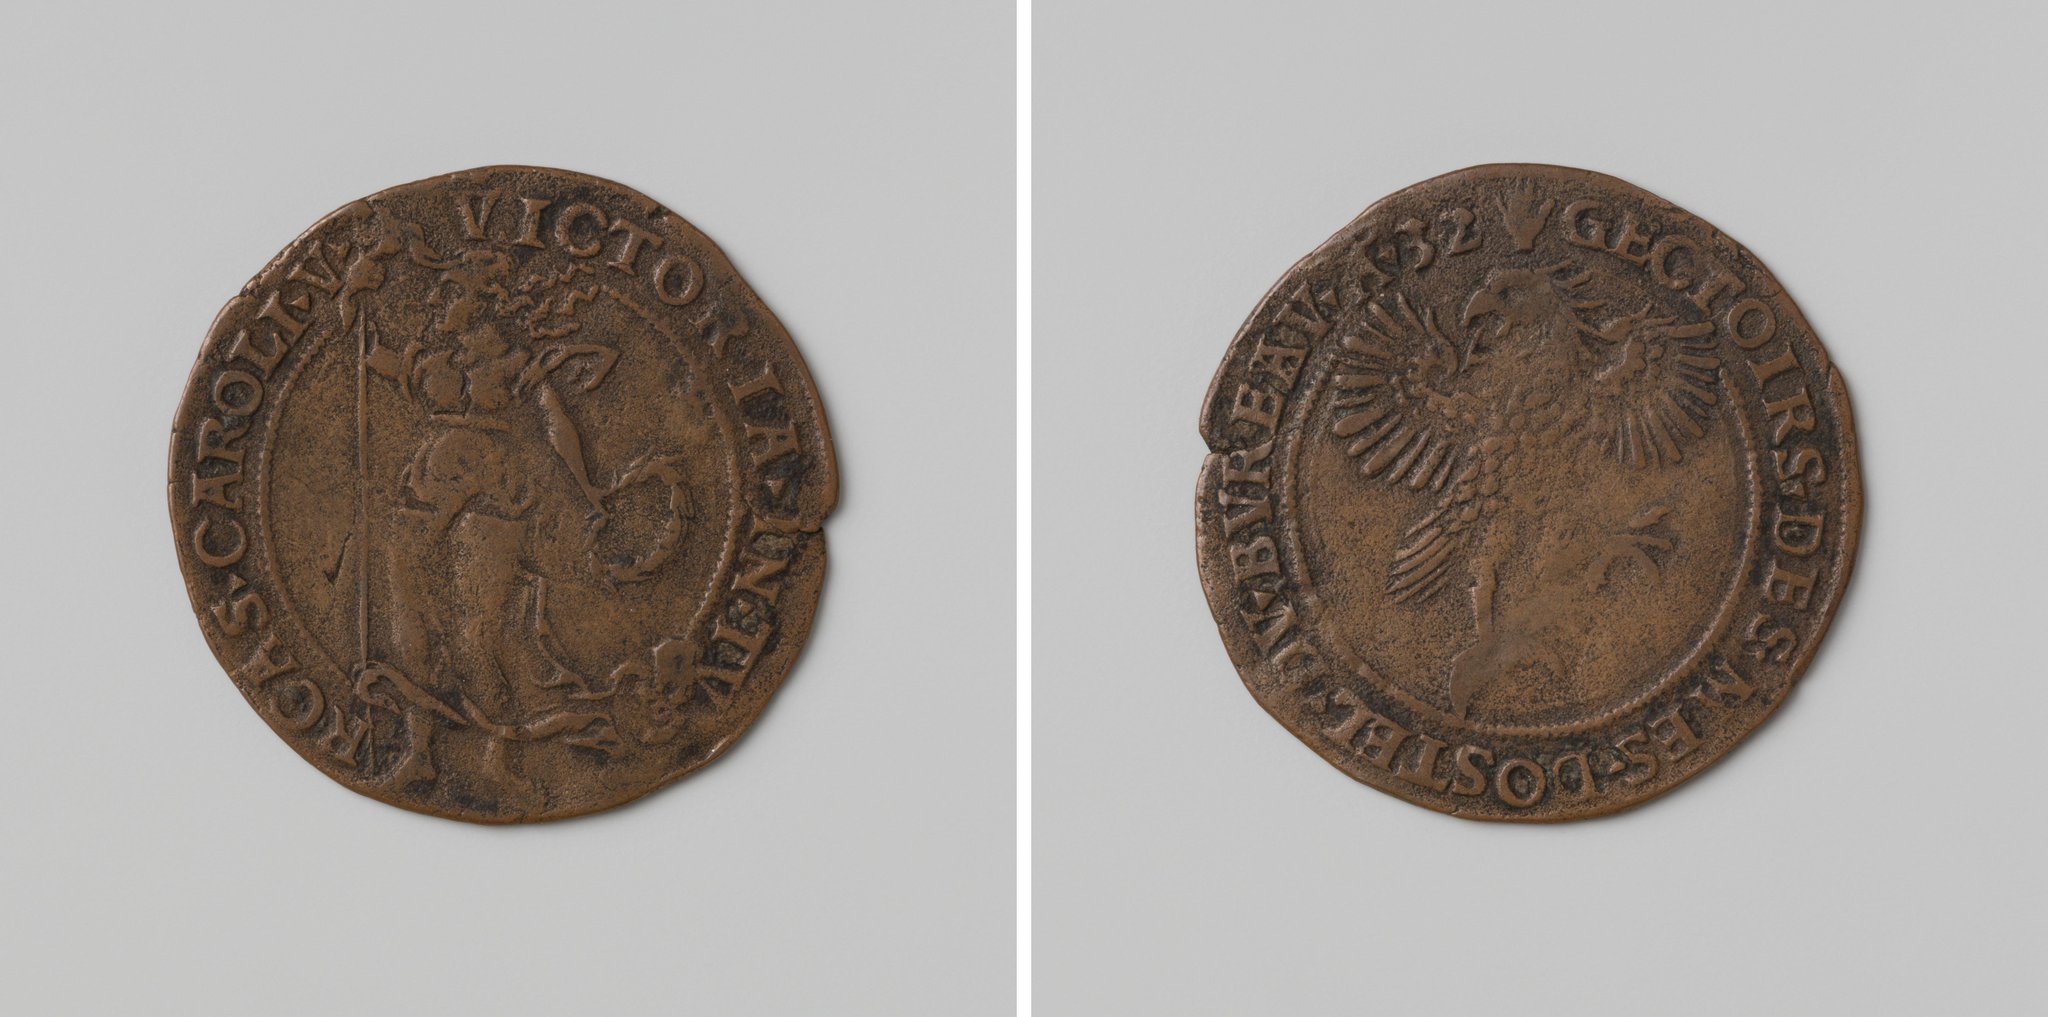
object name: jeton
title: Karel V, Duits keizer, verdrijft de Turken uit de Oostenrijkse Erflanden, rekenpenning van de rekenkamer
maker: Anonymous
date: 1532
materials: copper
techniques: striking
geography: antwerp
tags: ghent, charles v (holy roman emperor and king of spain), austria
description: Koperen penning. Voorzijde: Overwinning met lauwerkrans en banier in handen binnen omschrift. Keerzijde: adelaar met gespreide vleugels, staande op een poot binnen omschrift